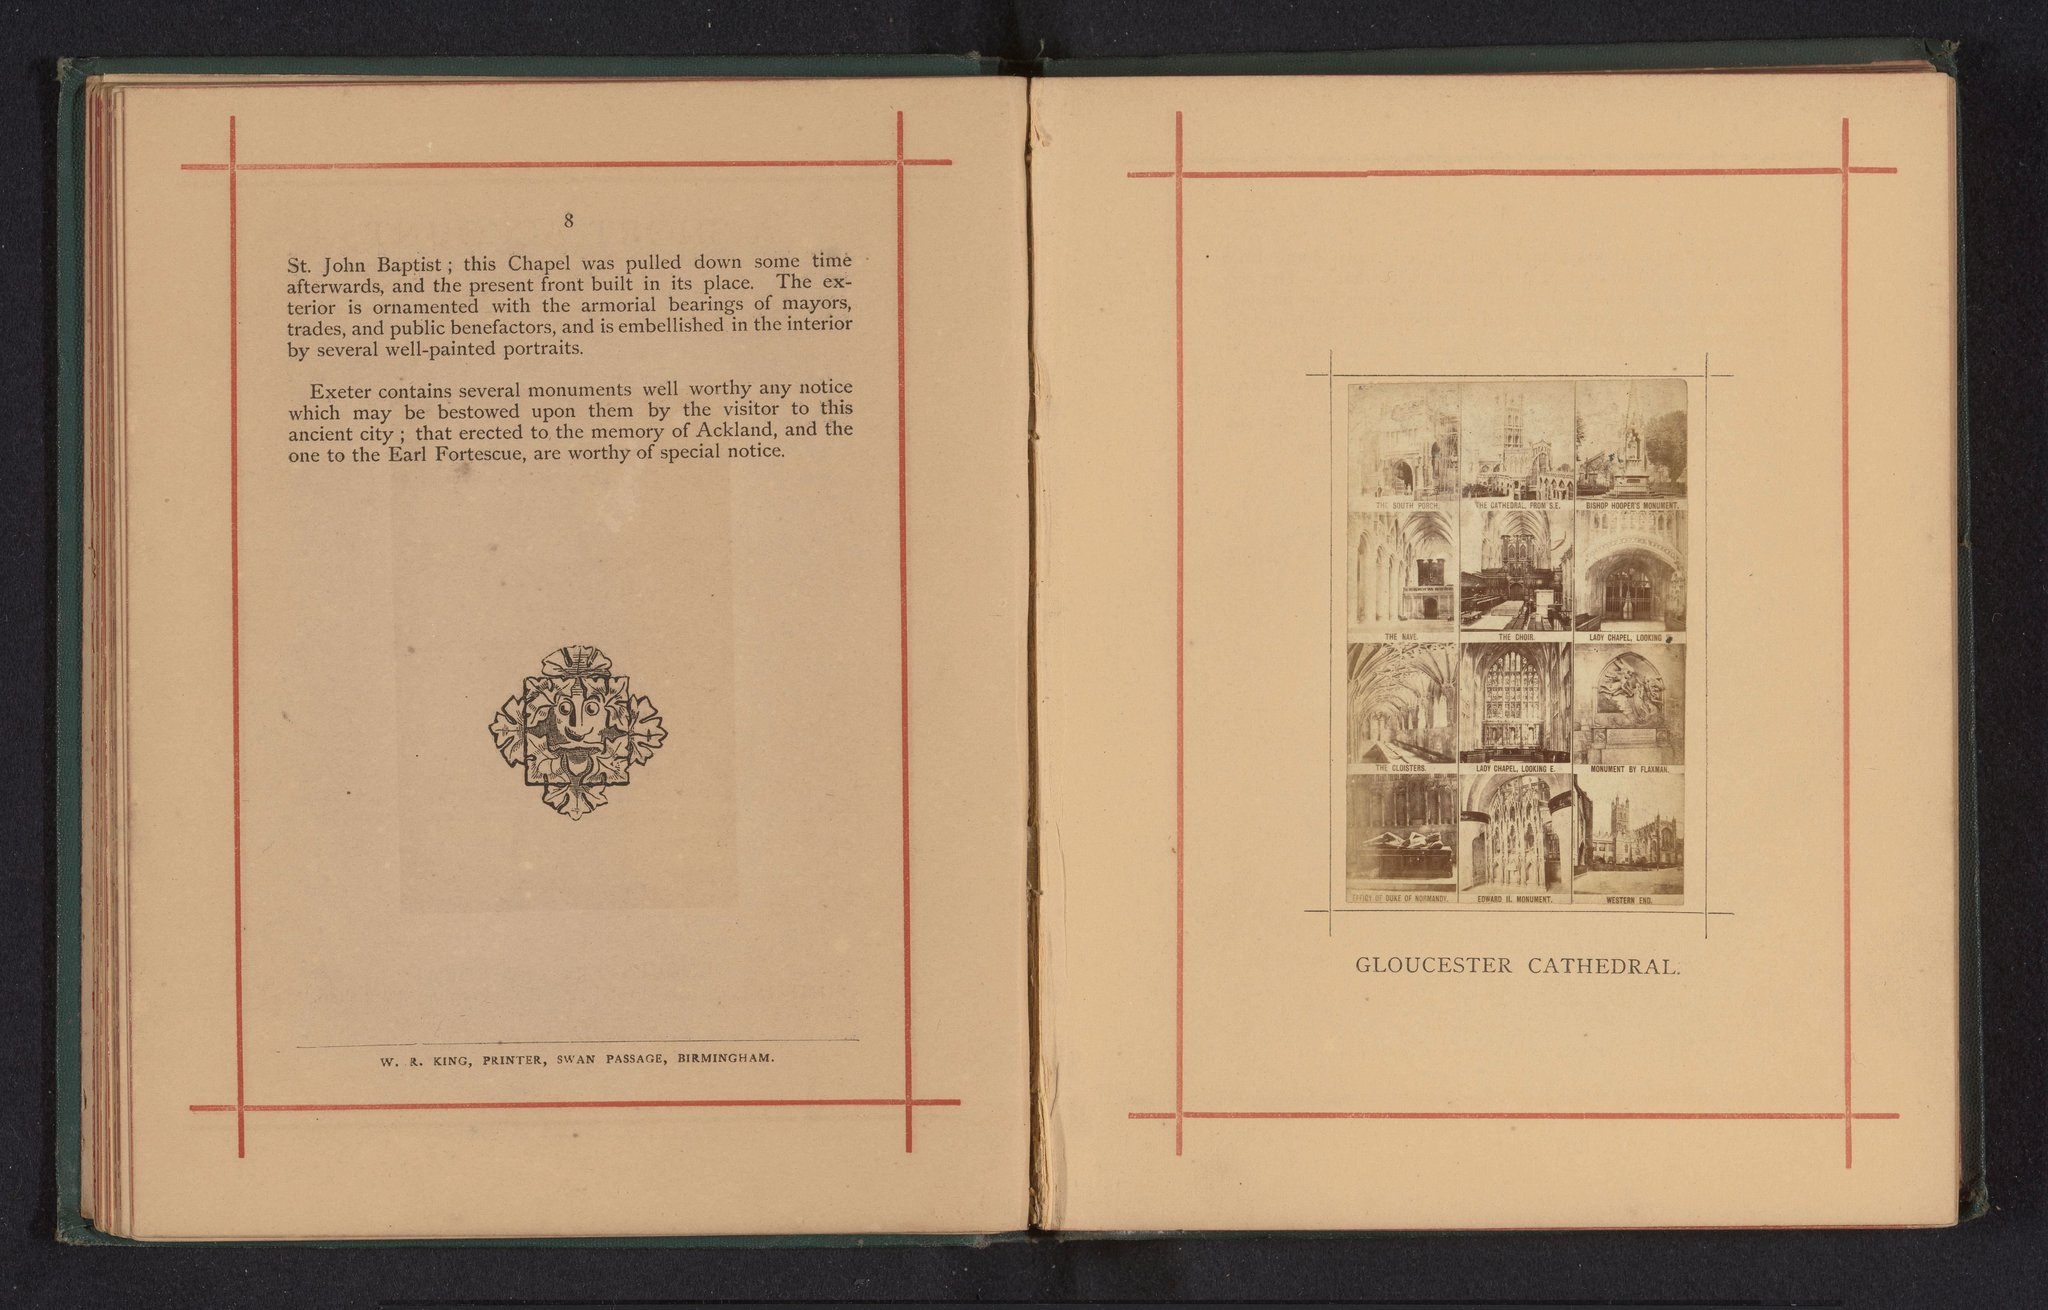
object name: reproduction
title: Fotoreproductie van twaalf foto's van de kathedraal van Gloucester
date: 1870-1880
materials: photographic support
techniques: albumen print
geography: gloucester cathedral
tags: church (exterior), parts of church interior: nave, monument, statue, parts of church interior: choir, parts of church interior: chapel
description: Van boven naar beneden en van links naar rechts: een zijbeuk, gezicht op de kathedraal, een monument, het schip, het koor, een kapel, een kloostergang, een kapel, driemaal een monument en een gezicht op de kathedraal